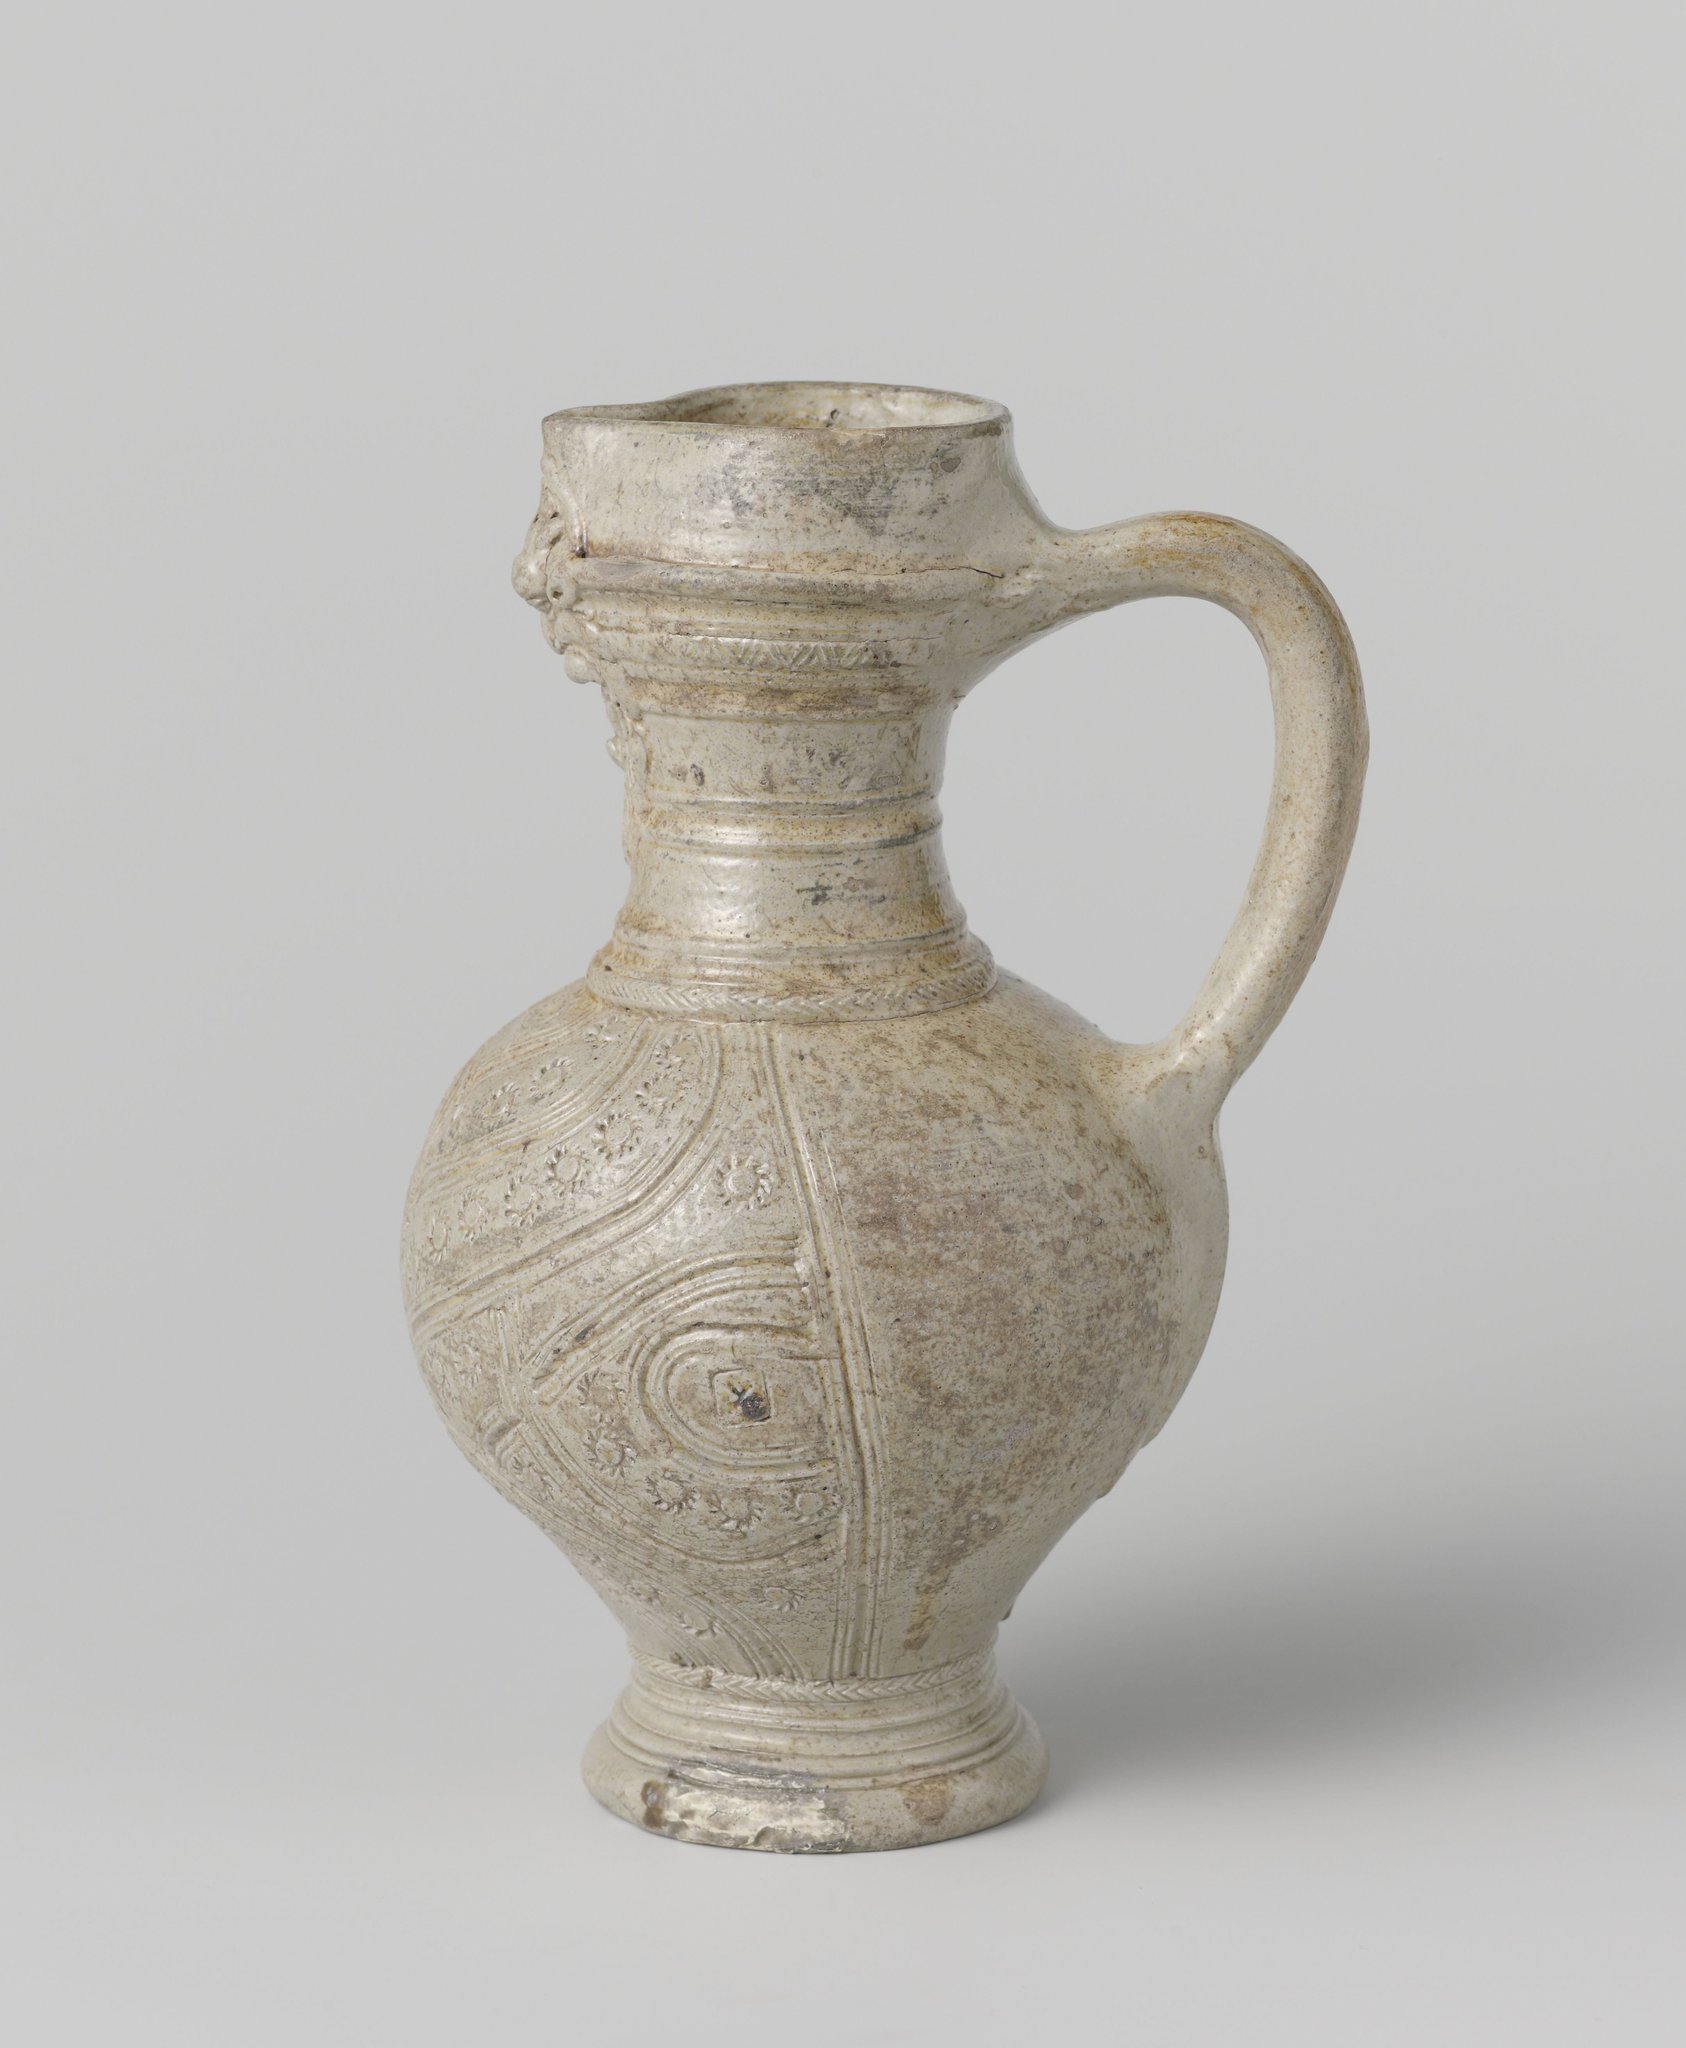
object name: ewer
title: Jug with a lion's head and roundels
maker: Anonymous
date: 1580-1620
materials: glaze, stoneware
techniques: printing, firing, forming, relief, turning, vitrification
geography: frechen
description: Kan van steengoed op hoge voet met een eivormig lichaam en spreidende nek met een opstaande rand met geknepen tuit. Het C-vormige oor is bevestigd aan de rand en de schouder. Profielen op de nek en voet. Op de voorzijde van de buik een vak met een patroon van ingegrifte banden met daartussen gestempelde rozetten. Op de nek een gedrukte en opgelegde leeuwenkop in reliëf. Frechen.